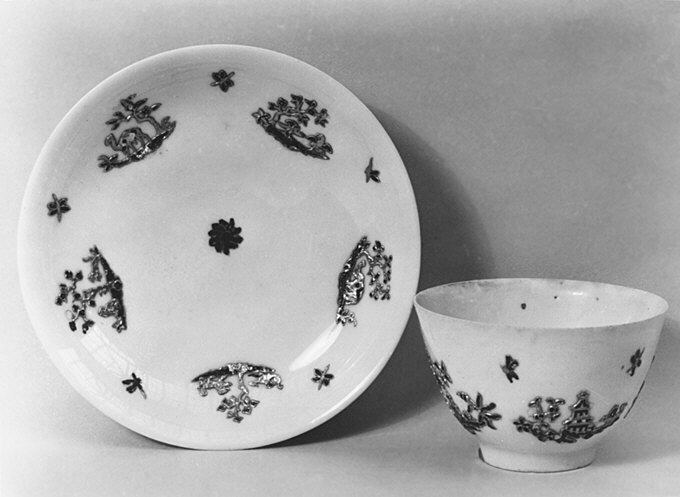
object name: teabowl and saucer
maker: meissen manufactory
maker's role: manufactory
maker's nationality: german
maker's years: 1710-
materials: hard paste porcelain